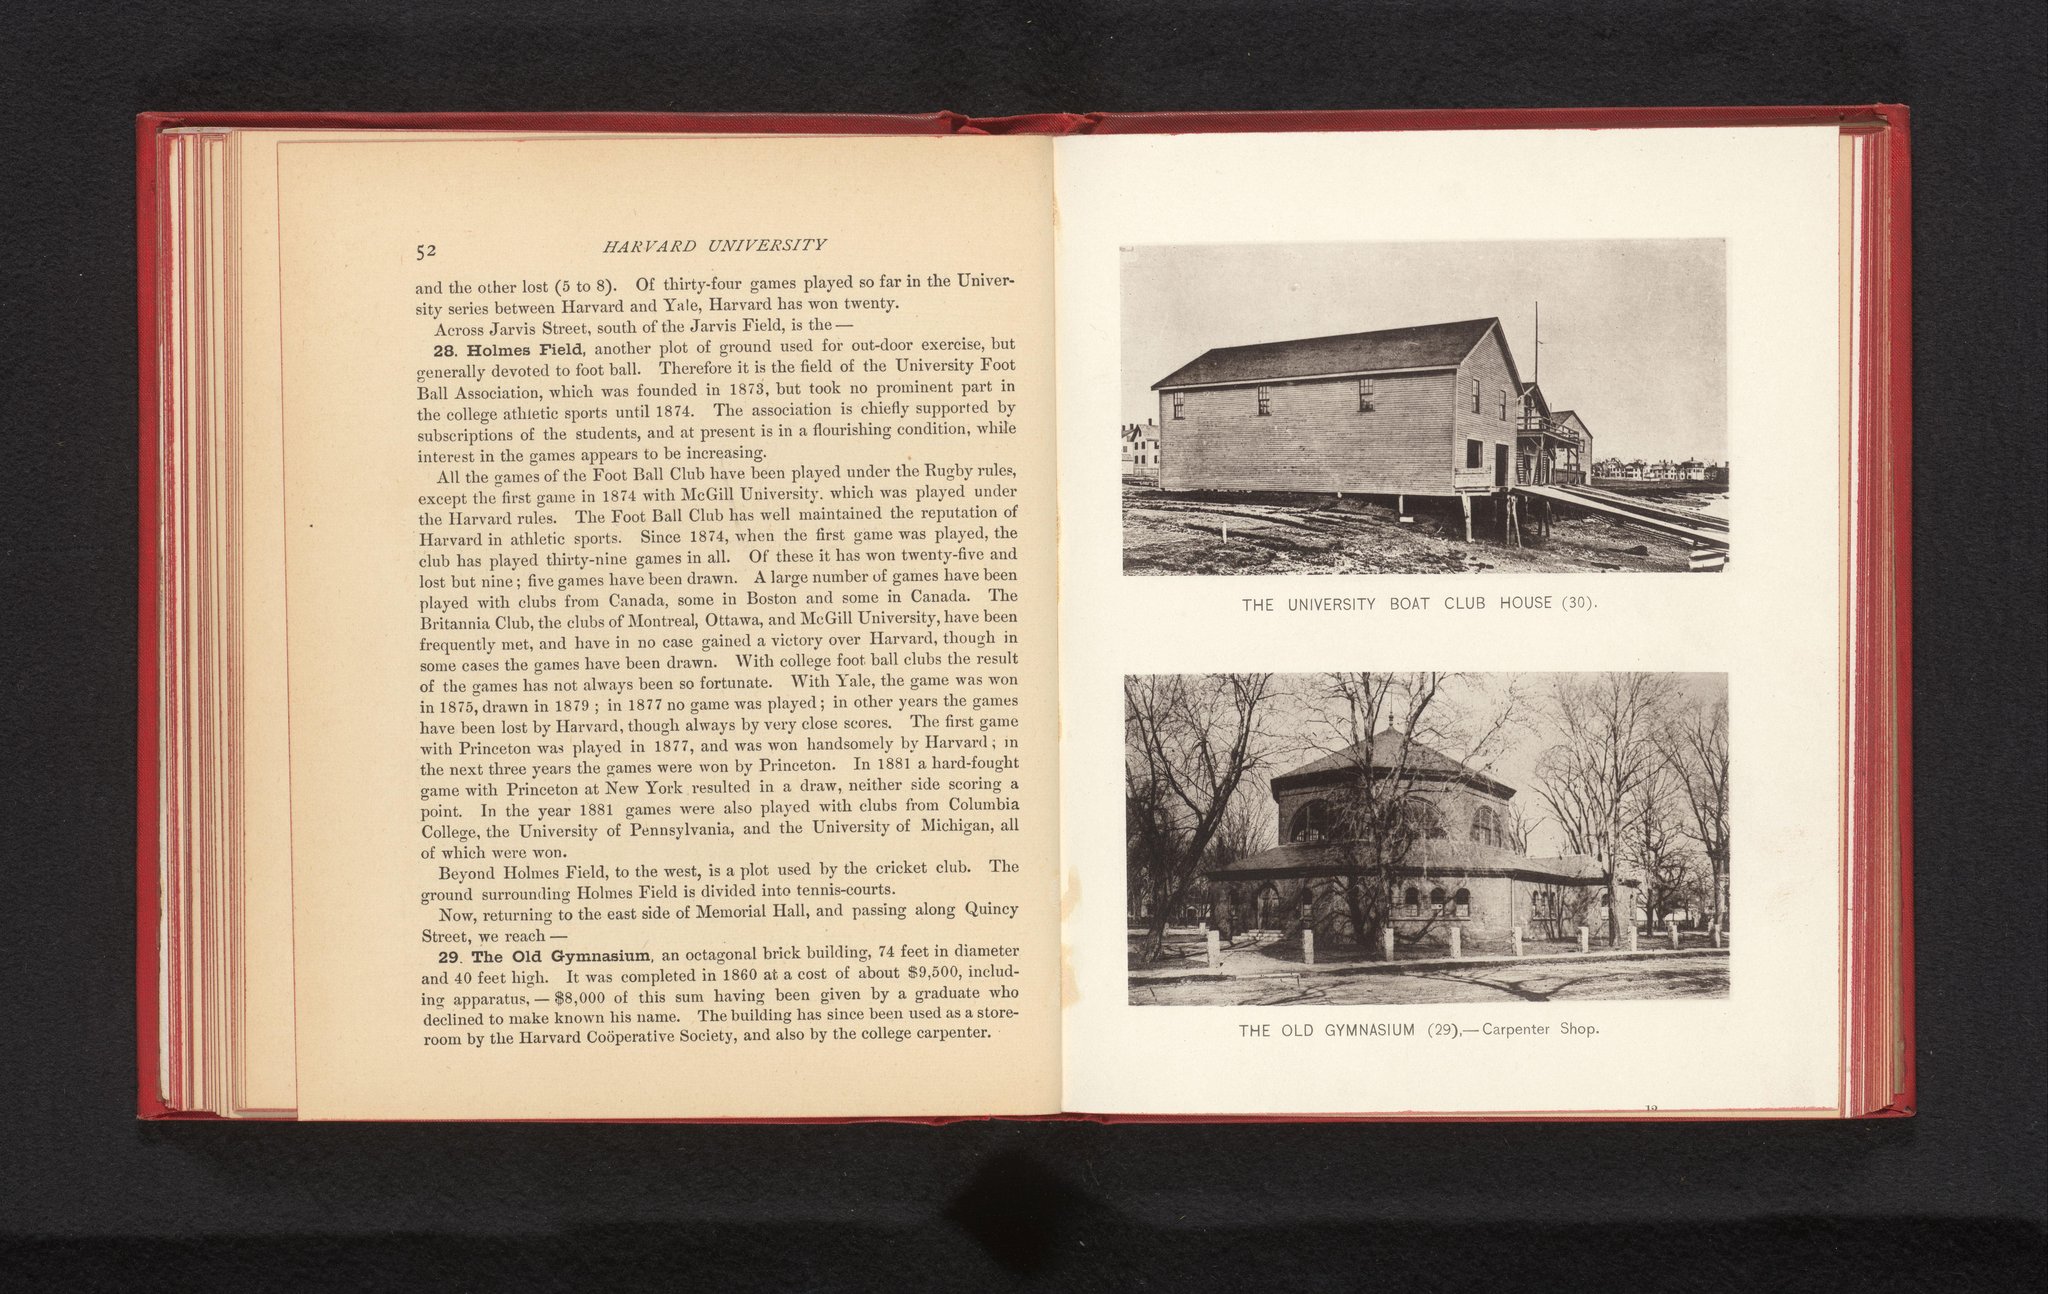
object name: page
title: The university boat club house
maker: Anonymous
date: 1881-1886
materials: paper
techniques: photograph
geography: cambridge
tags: university building, college, boat-house, shed, façade (of house or building)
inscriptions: number: ‘(30) (29)’